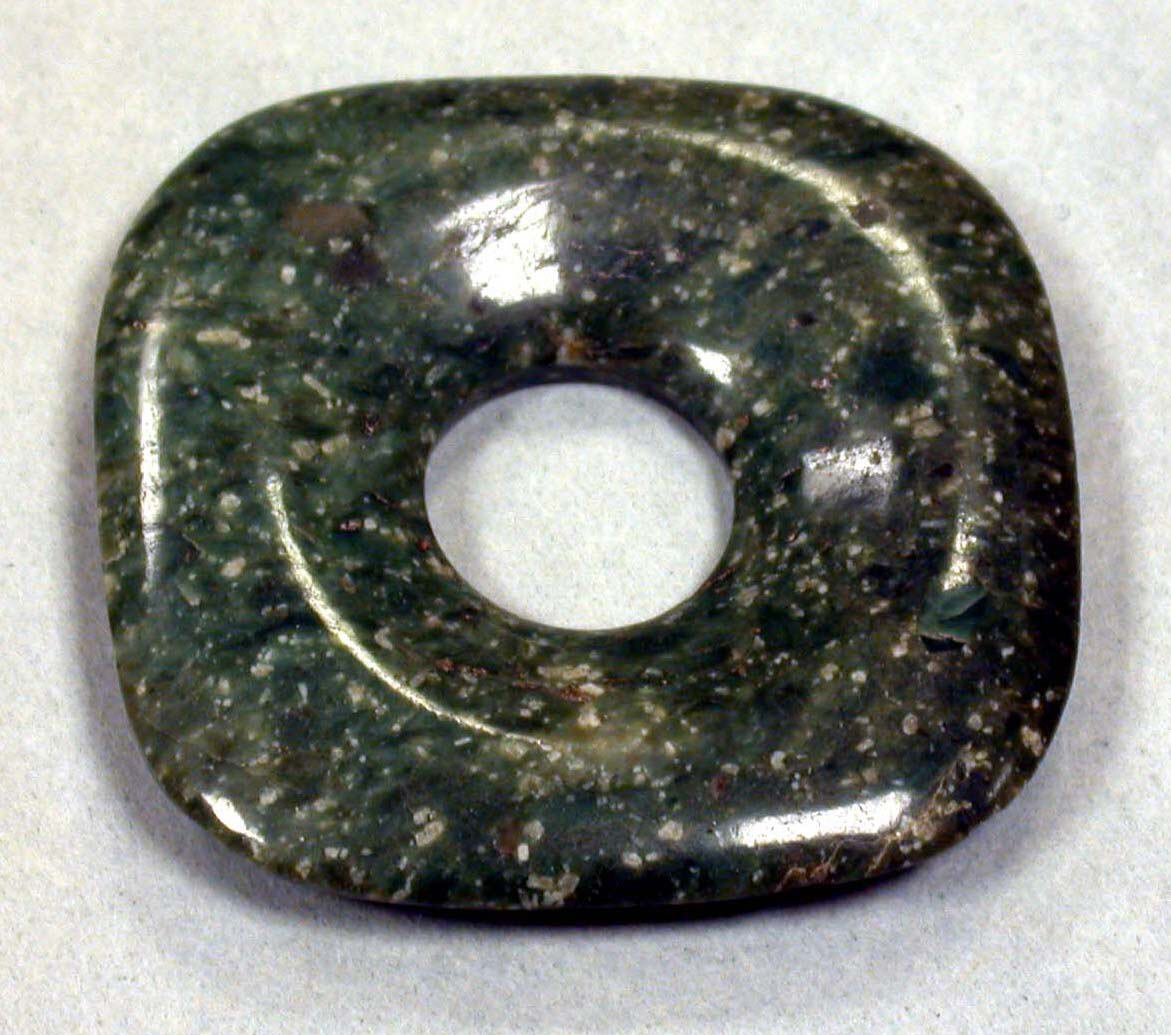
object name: earflare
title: Stone Ear Flare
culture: mexican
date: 1501-1600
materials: stone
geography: mexico